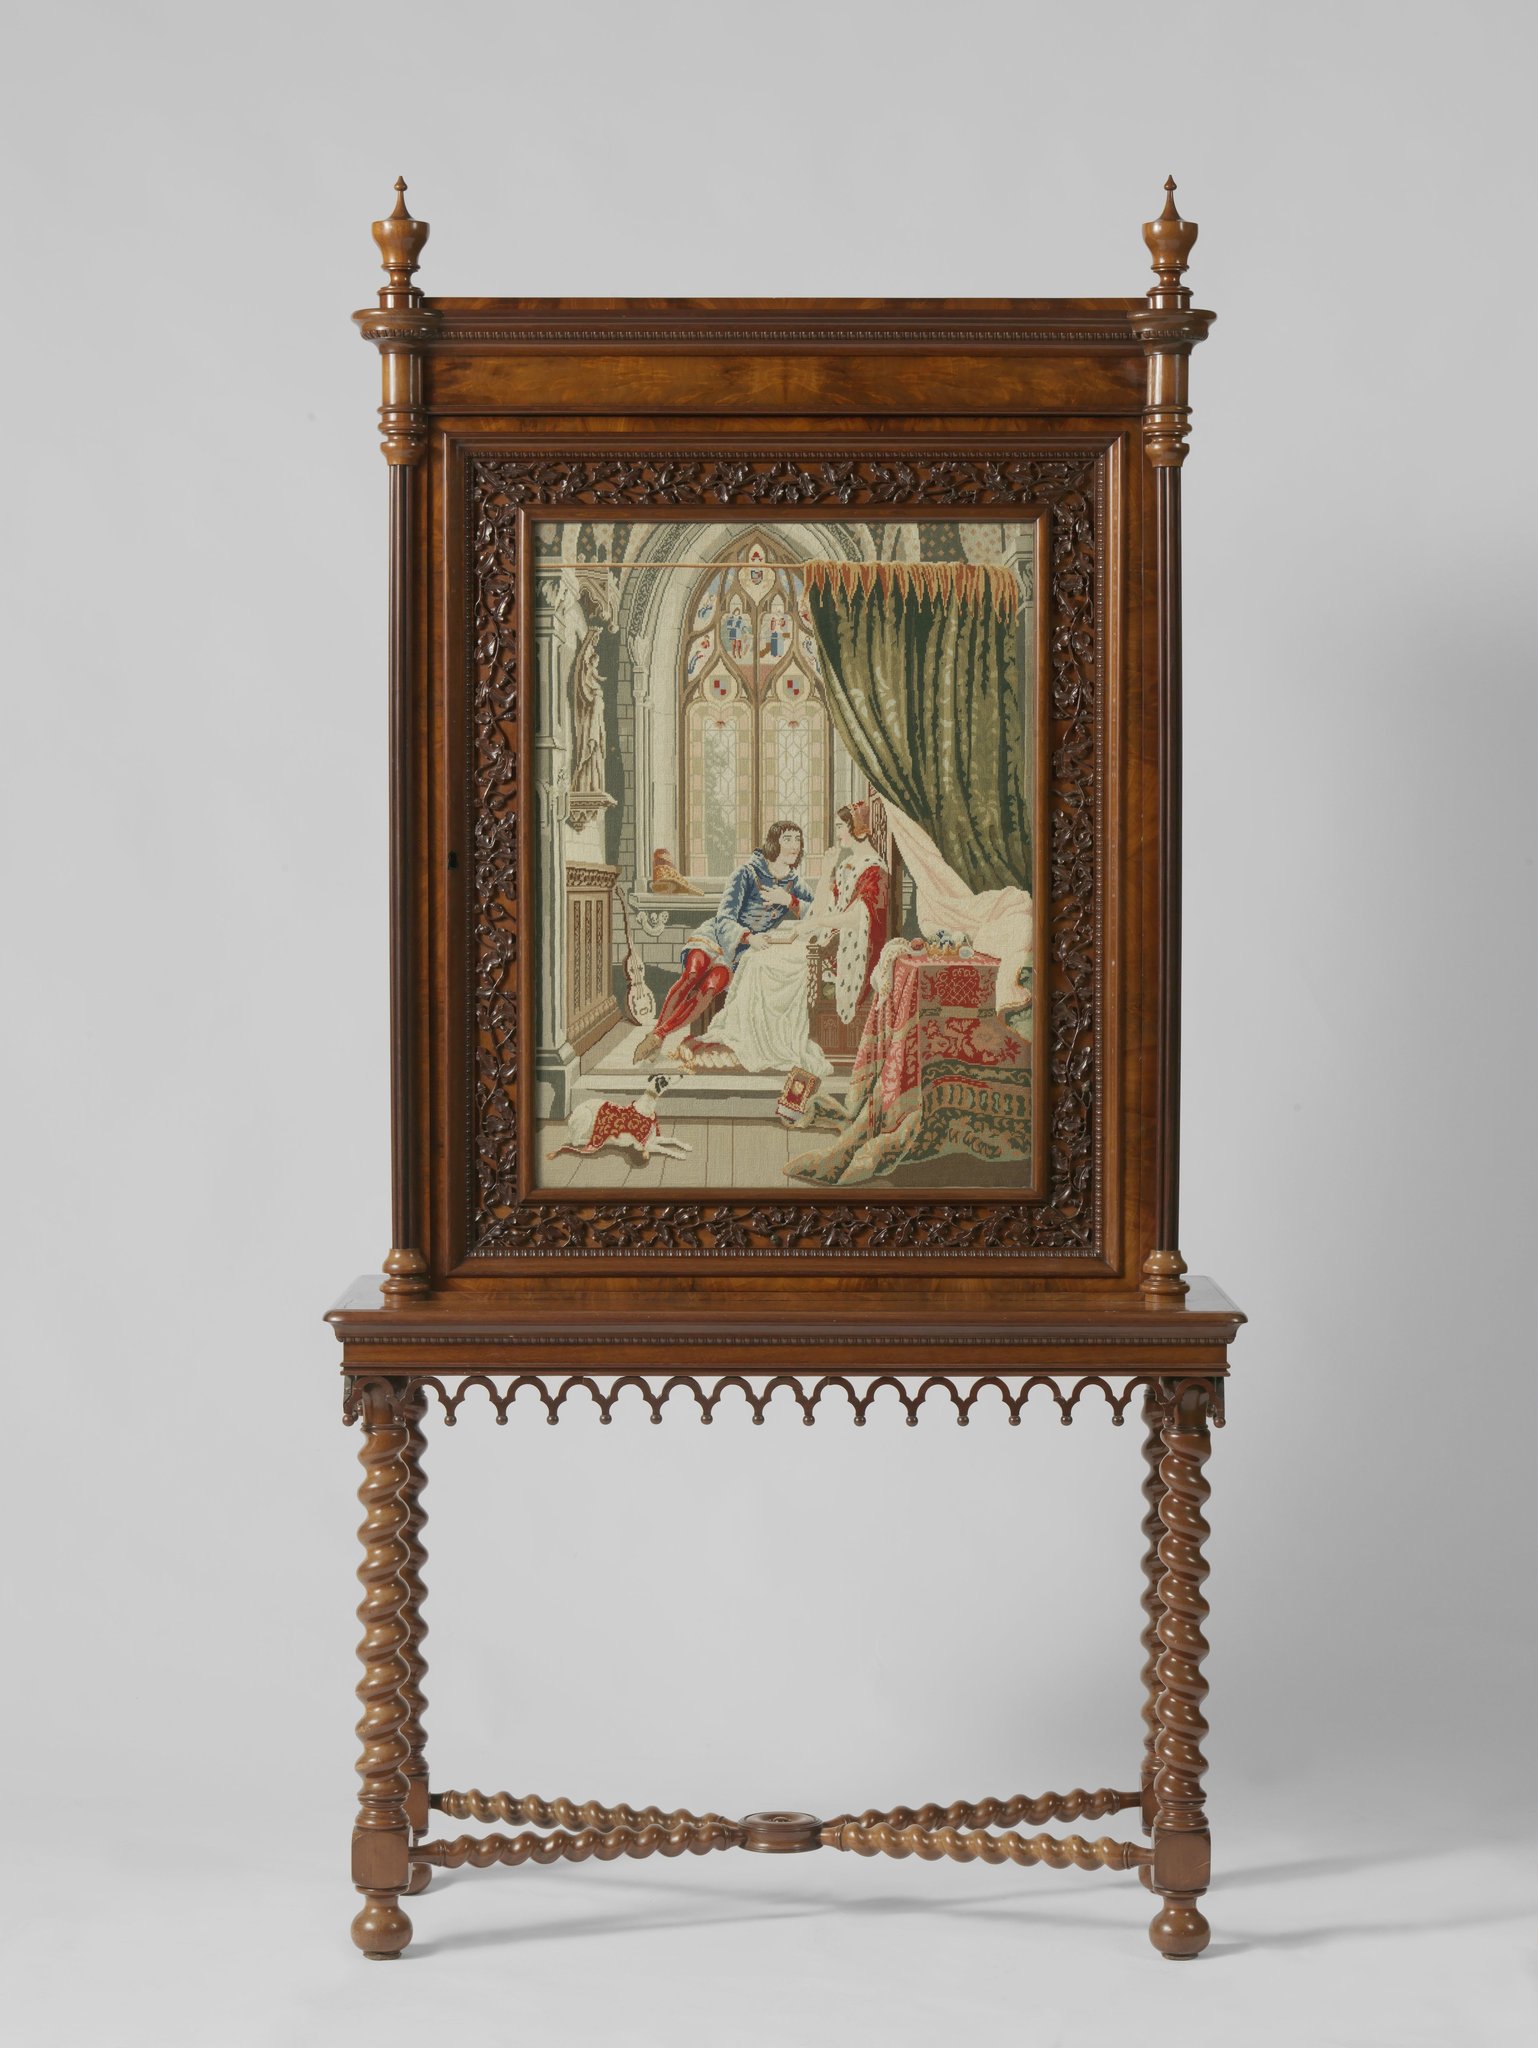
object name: bookcase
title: Neo-gothische boekenkast (bovenstuk)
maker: Anonymous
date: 1835-1845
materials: glass, wood, silk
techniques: embroidered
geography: netherlands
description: Bovenstuk van een neo-gothische boekenkast, ingelegd met een geborduurd paneel.